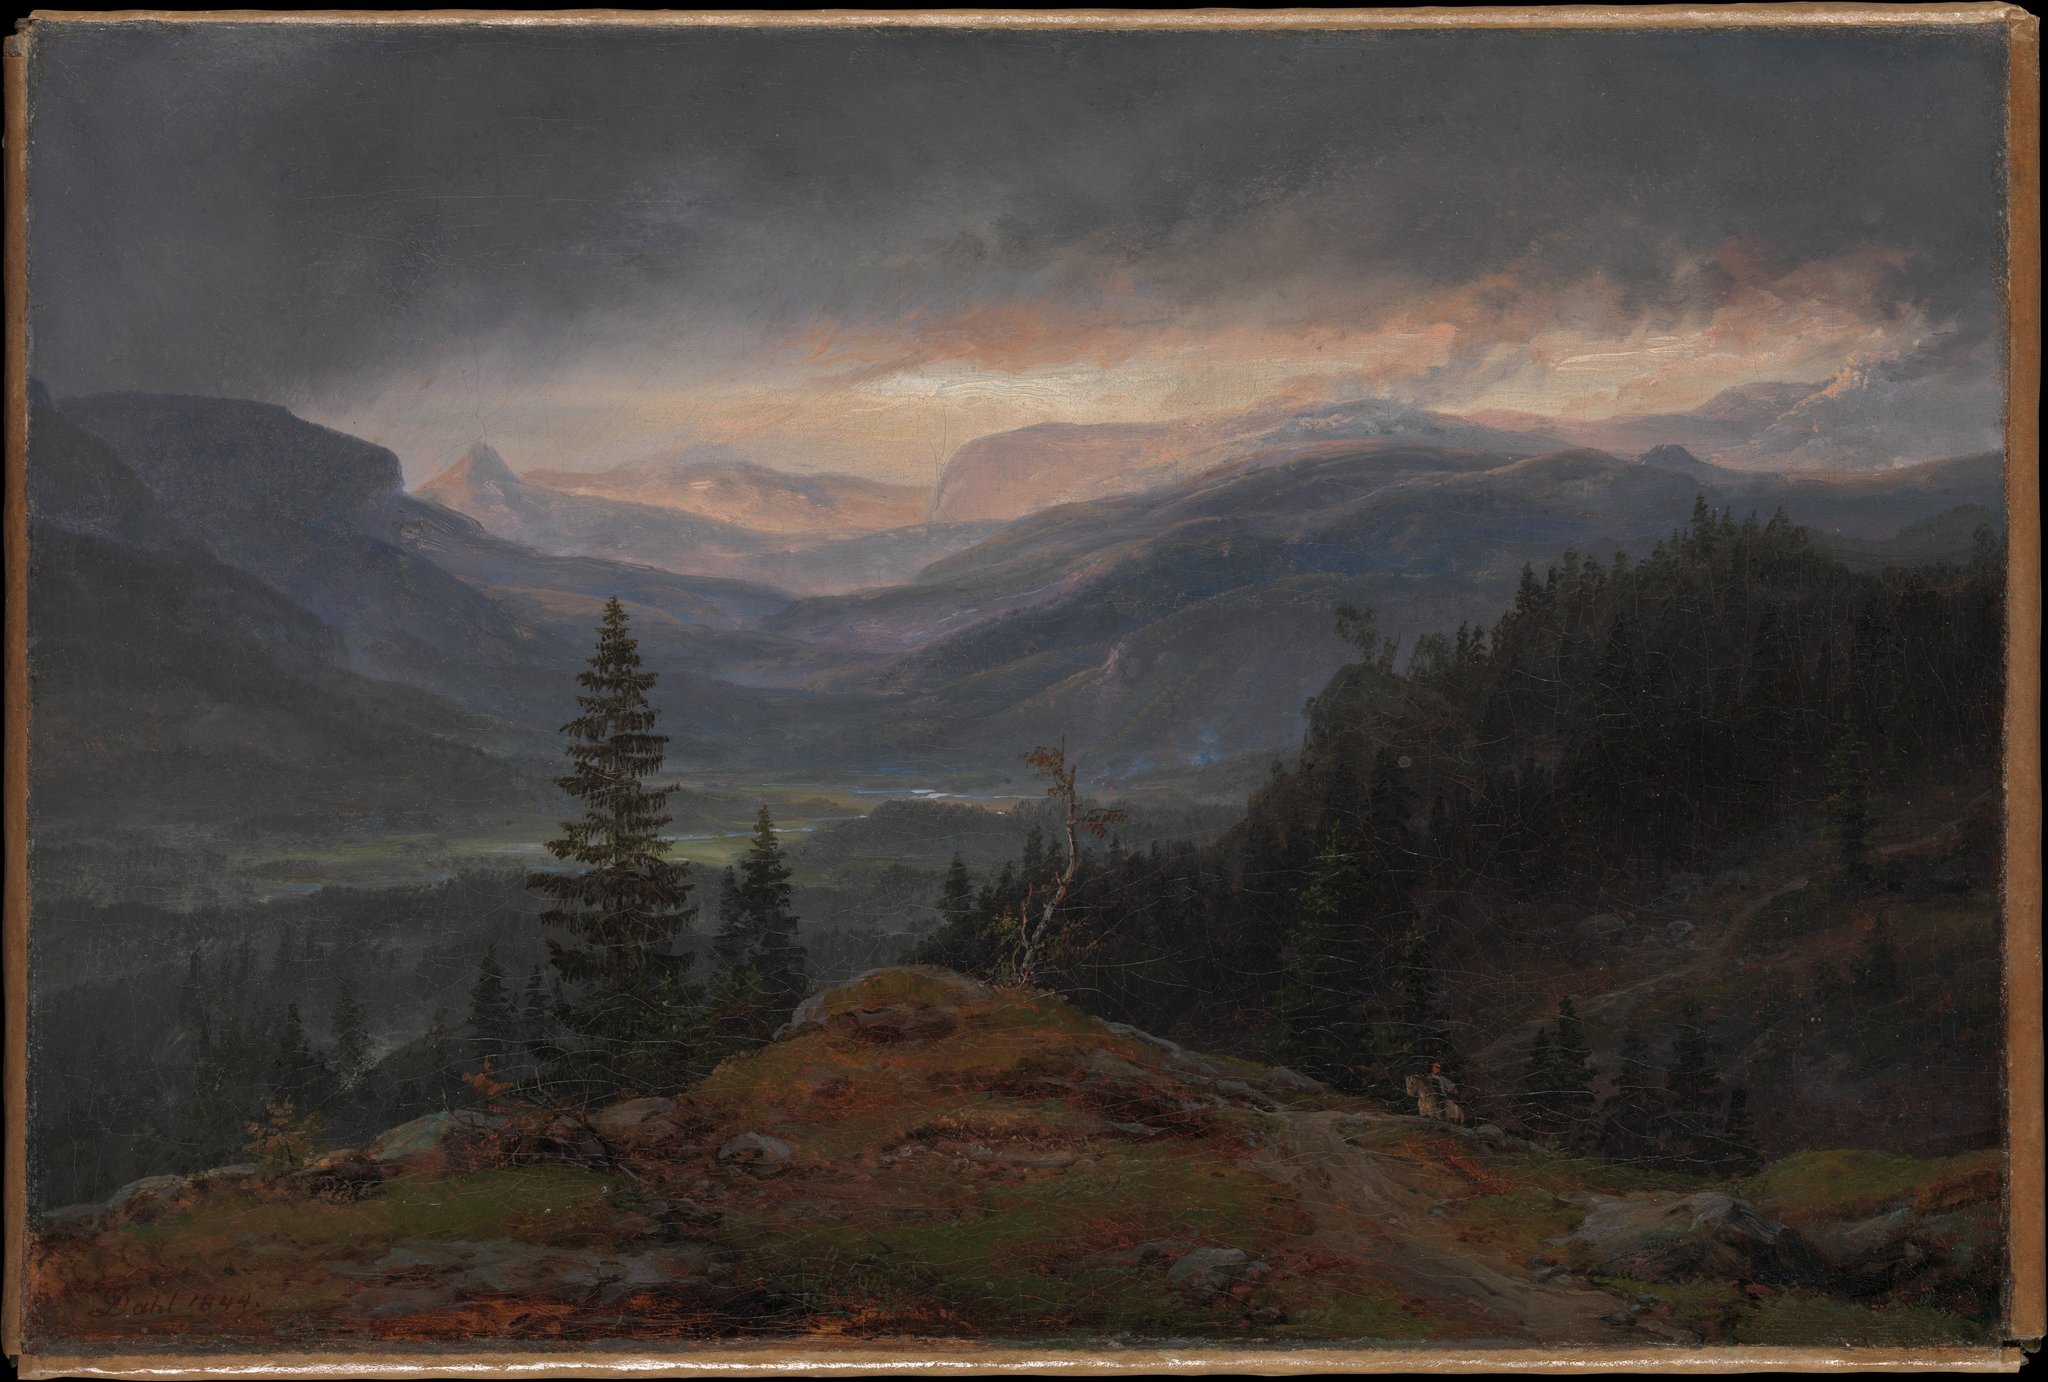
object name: painting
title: View over Hallingdal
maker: johan christian dahl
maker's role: artist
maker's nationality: norwegian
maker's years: 1788-1857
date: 1844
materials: canvas, oil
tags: landscapes